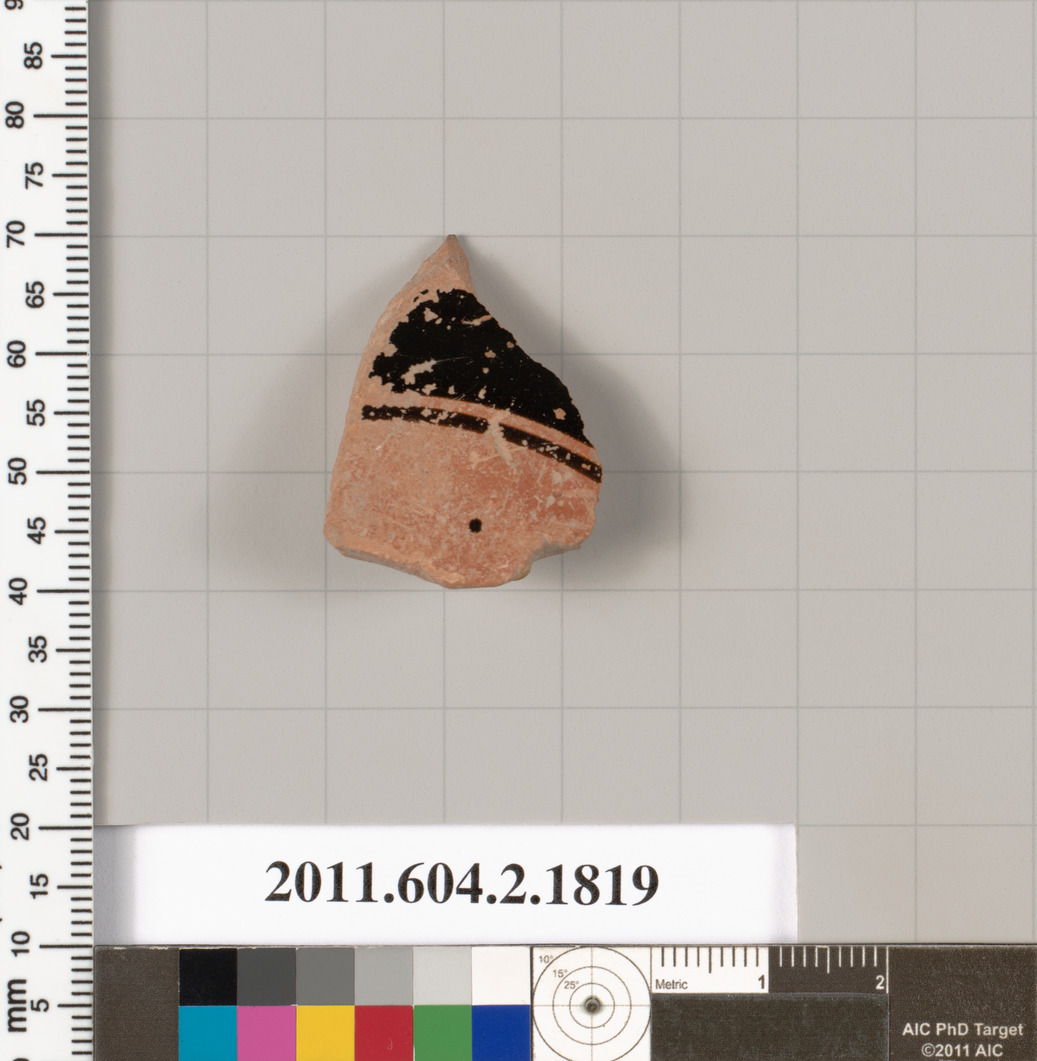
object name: skyphos fragment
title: Terracotta fragment of a skyphos (deep drinking cup)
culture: greek, attic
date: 450-401 BCE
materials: terracotta